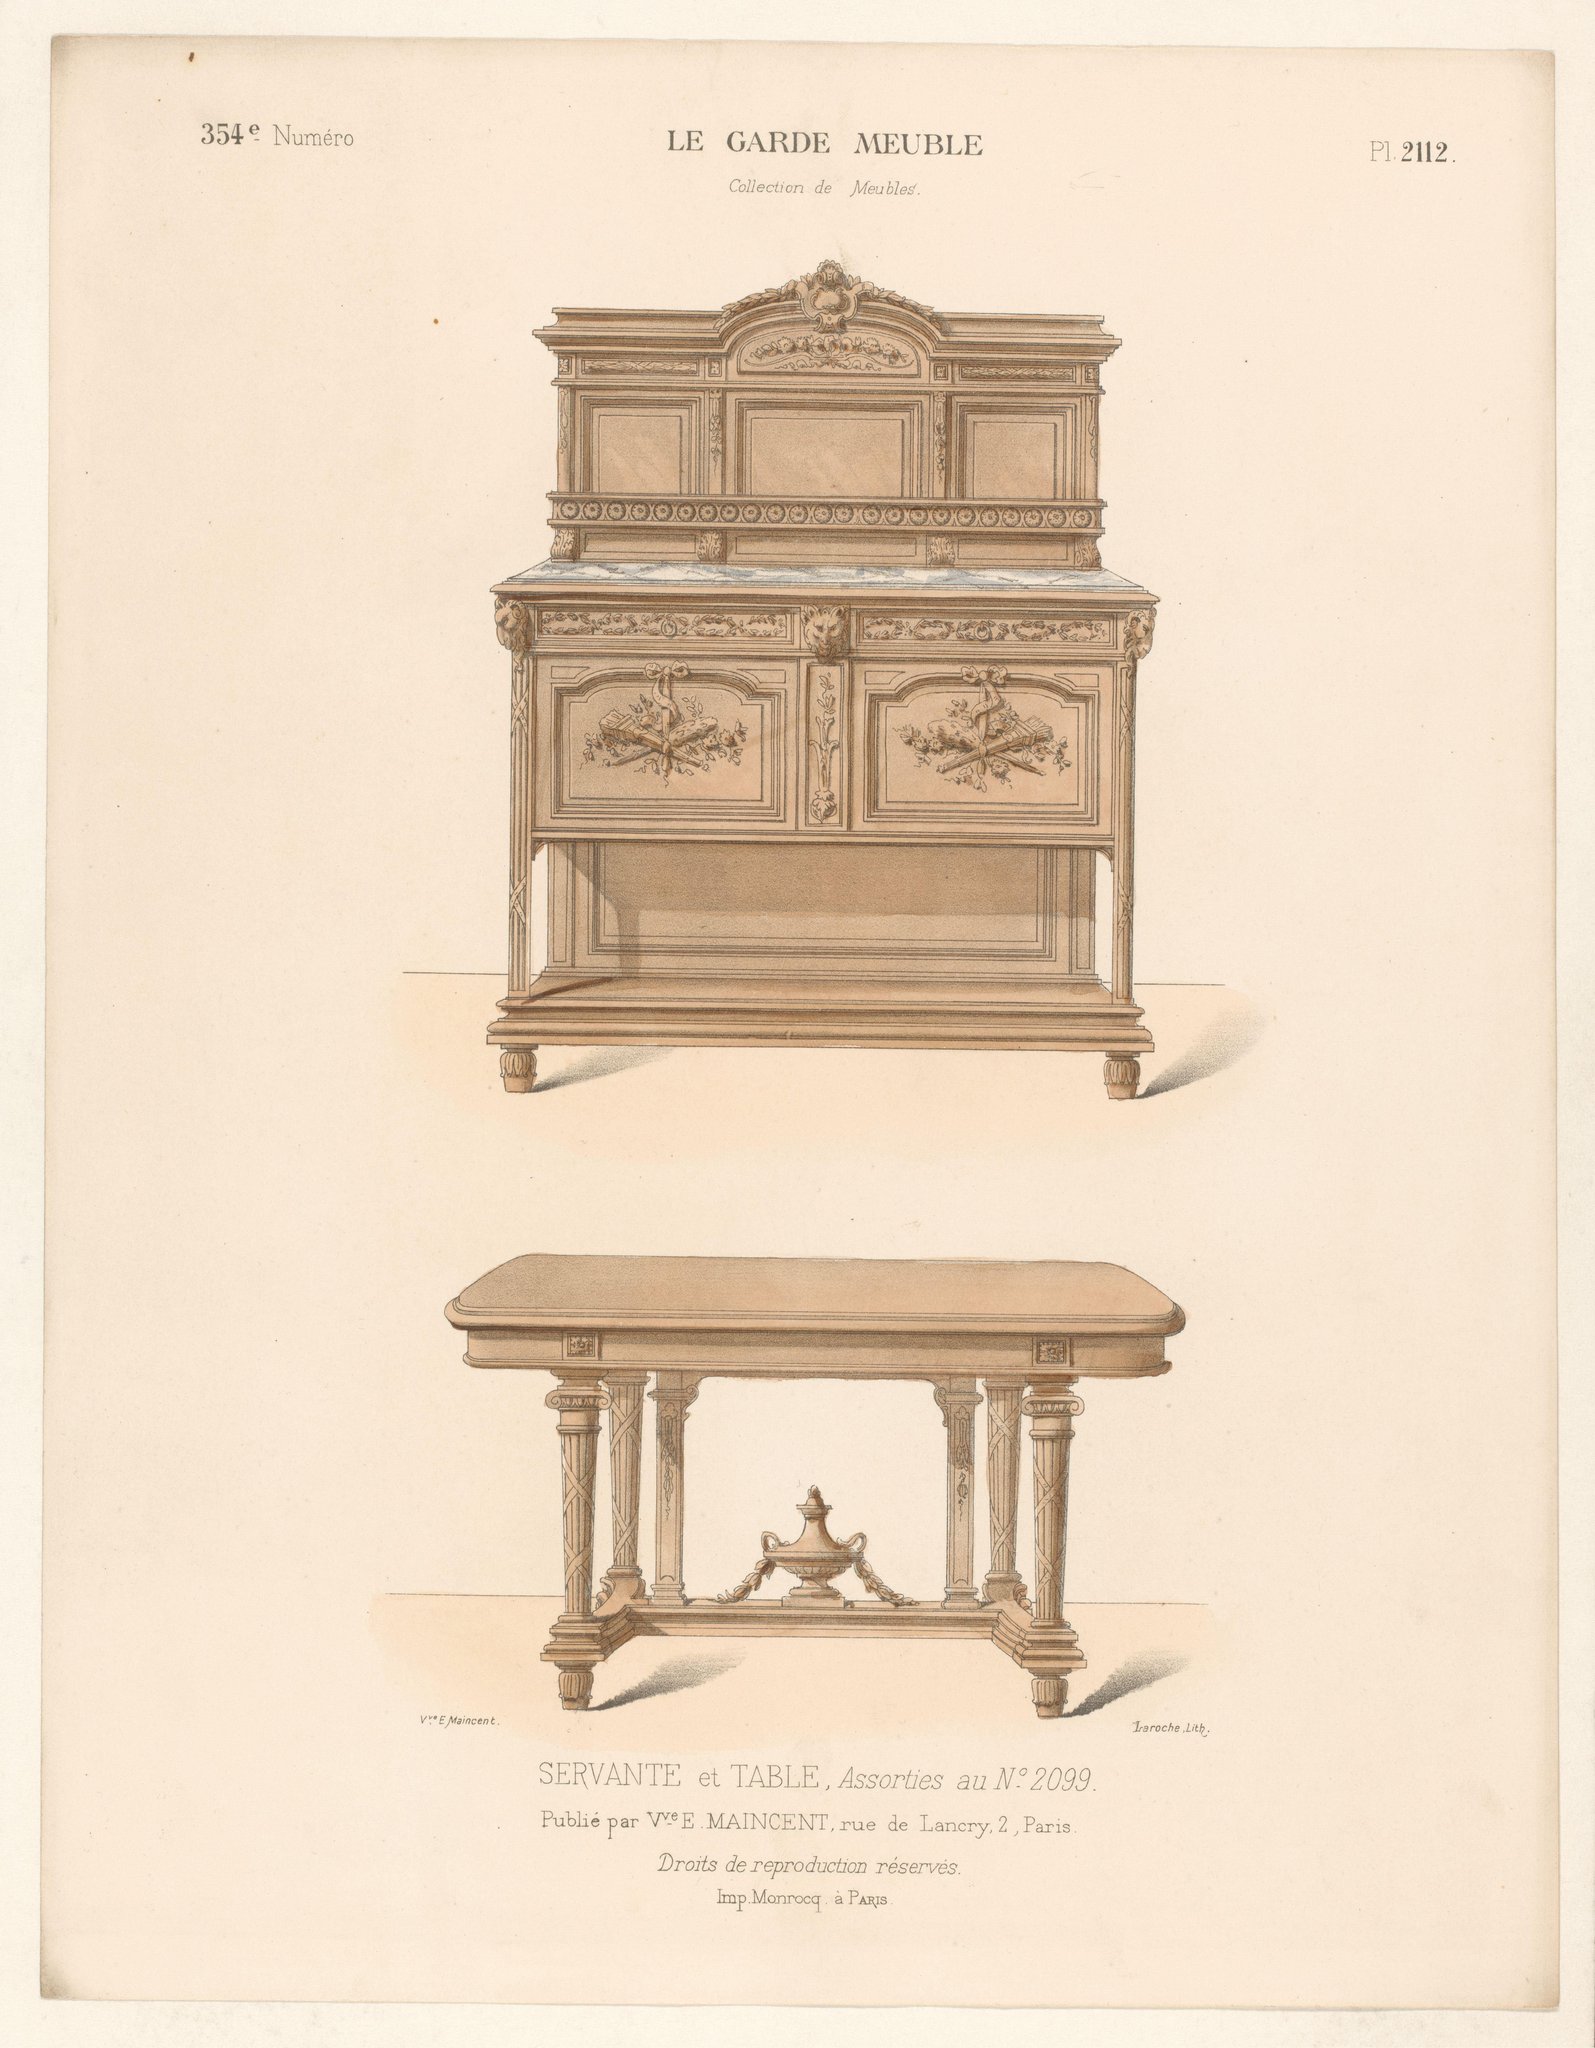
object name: print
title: Servante et table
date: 1895-1935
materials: paper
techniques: hand coloring, lithograph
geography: paris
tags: furniture for storage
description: Ieder Livraison in de serie Le Garde-Meuble bevat negen platen: drie 'sièges' (zitmeubels), drie 'meubles' (diverse meubels zoals tafels en kasten) en drie 'tentures' (gordijnen en draperieën).